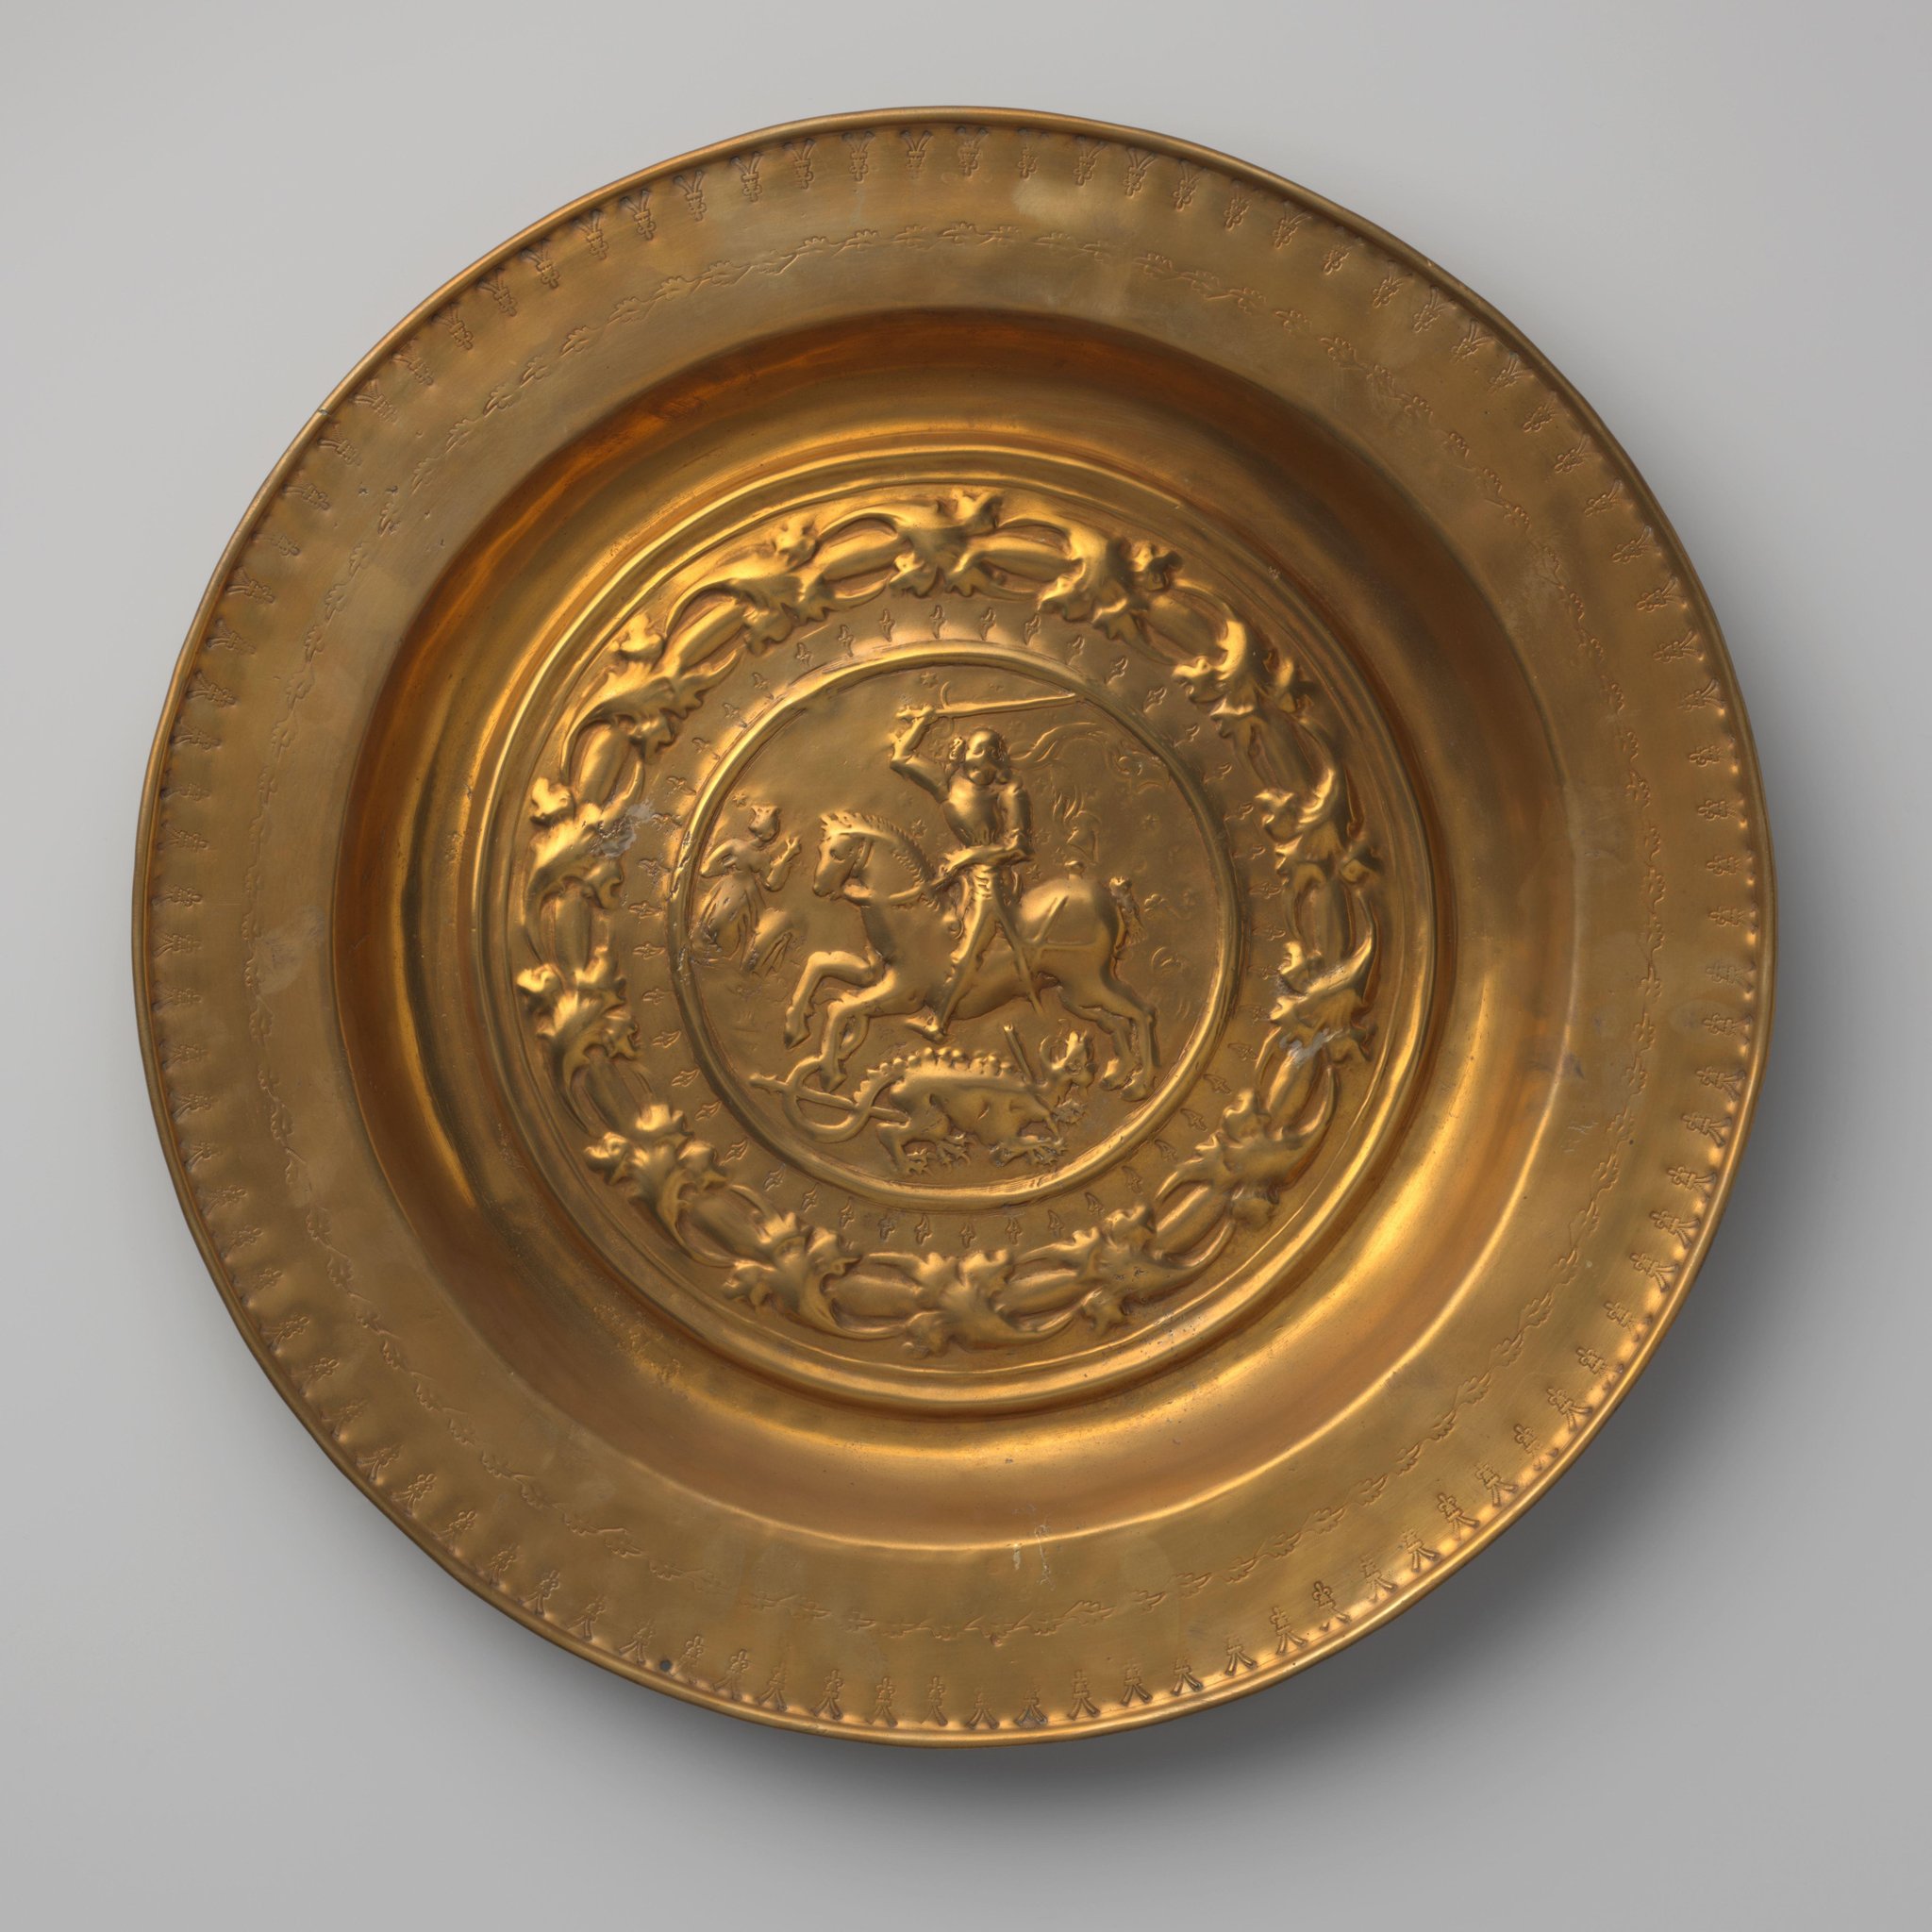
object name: platter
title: Schaal met H. Joris en de draak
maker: Anonymous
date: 1500-1600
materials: brass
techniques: casting, punching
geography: nuremberg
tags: the warrior martyr george (georgius); possible attributes: banner (red cross on white field), (red) cross, dragon, (white) horse, broken lance, shield (with cross), sword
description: In het plat van de schotel, waar in het midden het centerpunt zichtbaar is, zijn met behulp van stempelvormen geponst: een aan de Legenda Aurea ontleende voorstelling van de H. Joris te paard in gevecht met de draak en de koningsdochter links op de achtergrond, en een door gestileerd bladornament omwikkelde ribbe. Daartussen is een geponst ornament van bladmotieven aangebracht. De boord heeft geponst bladornament in het midden en geponste kruisbloemen aan de rand. De rand is om een ijzerdraad geslagen. De hangringen aan de achterzijde en het gat in de rand zijn later aangebracht.